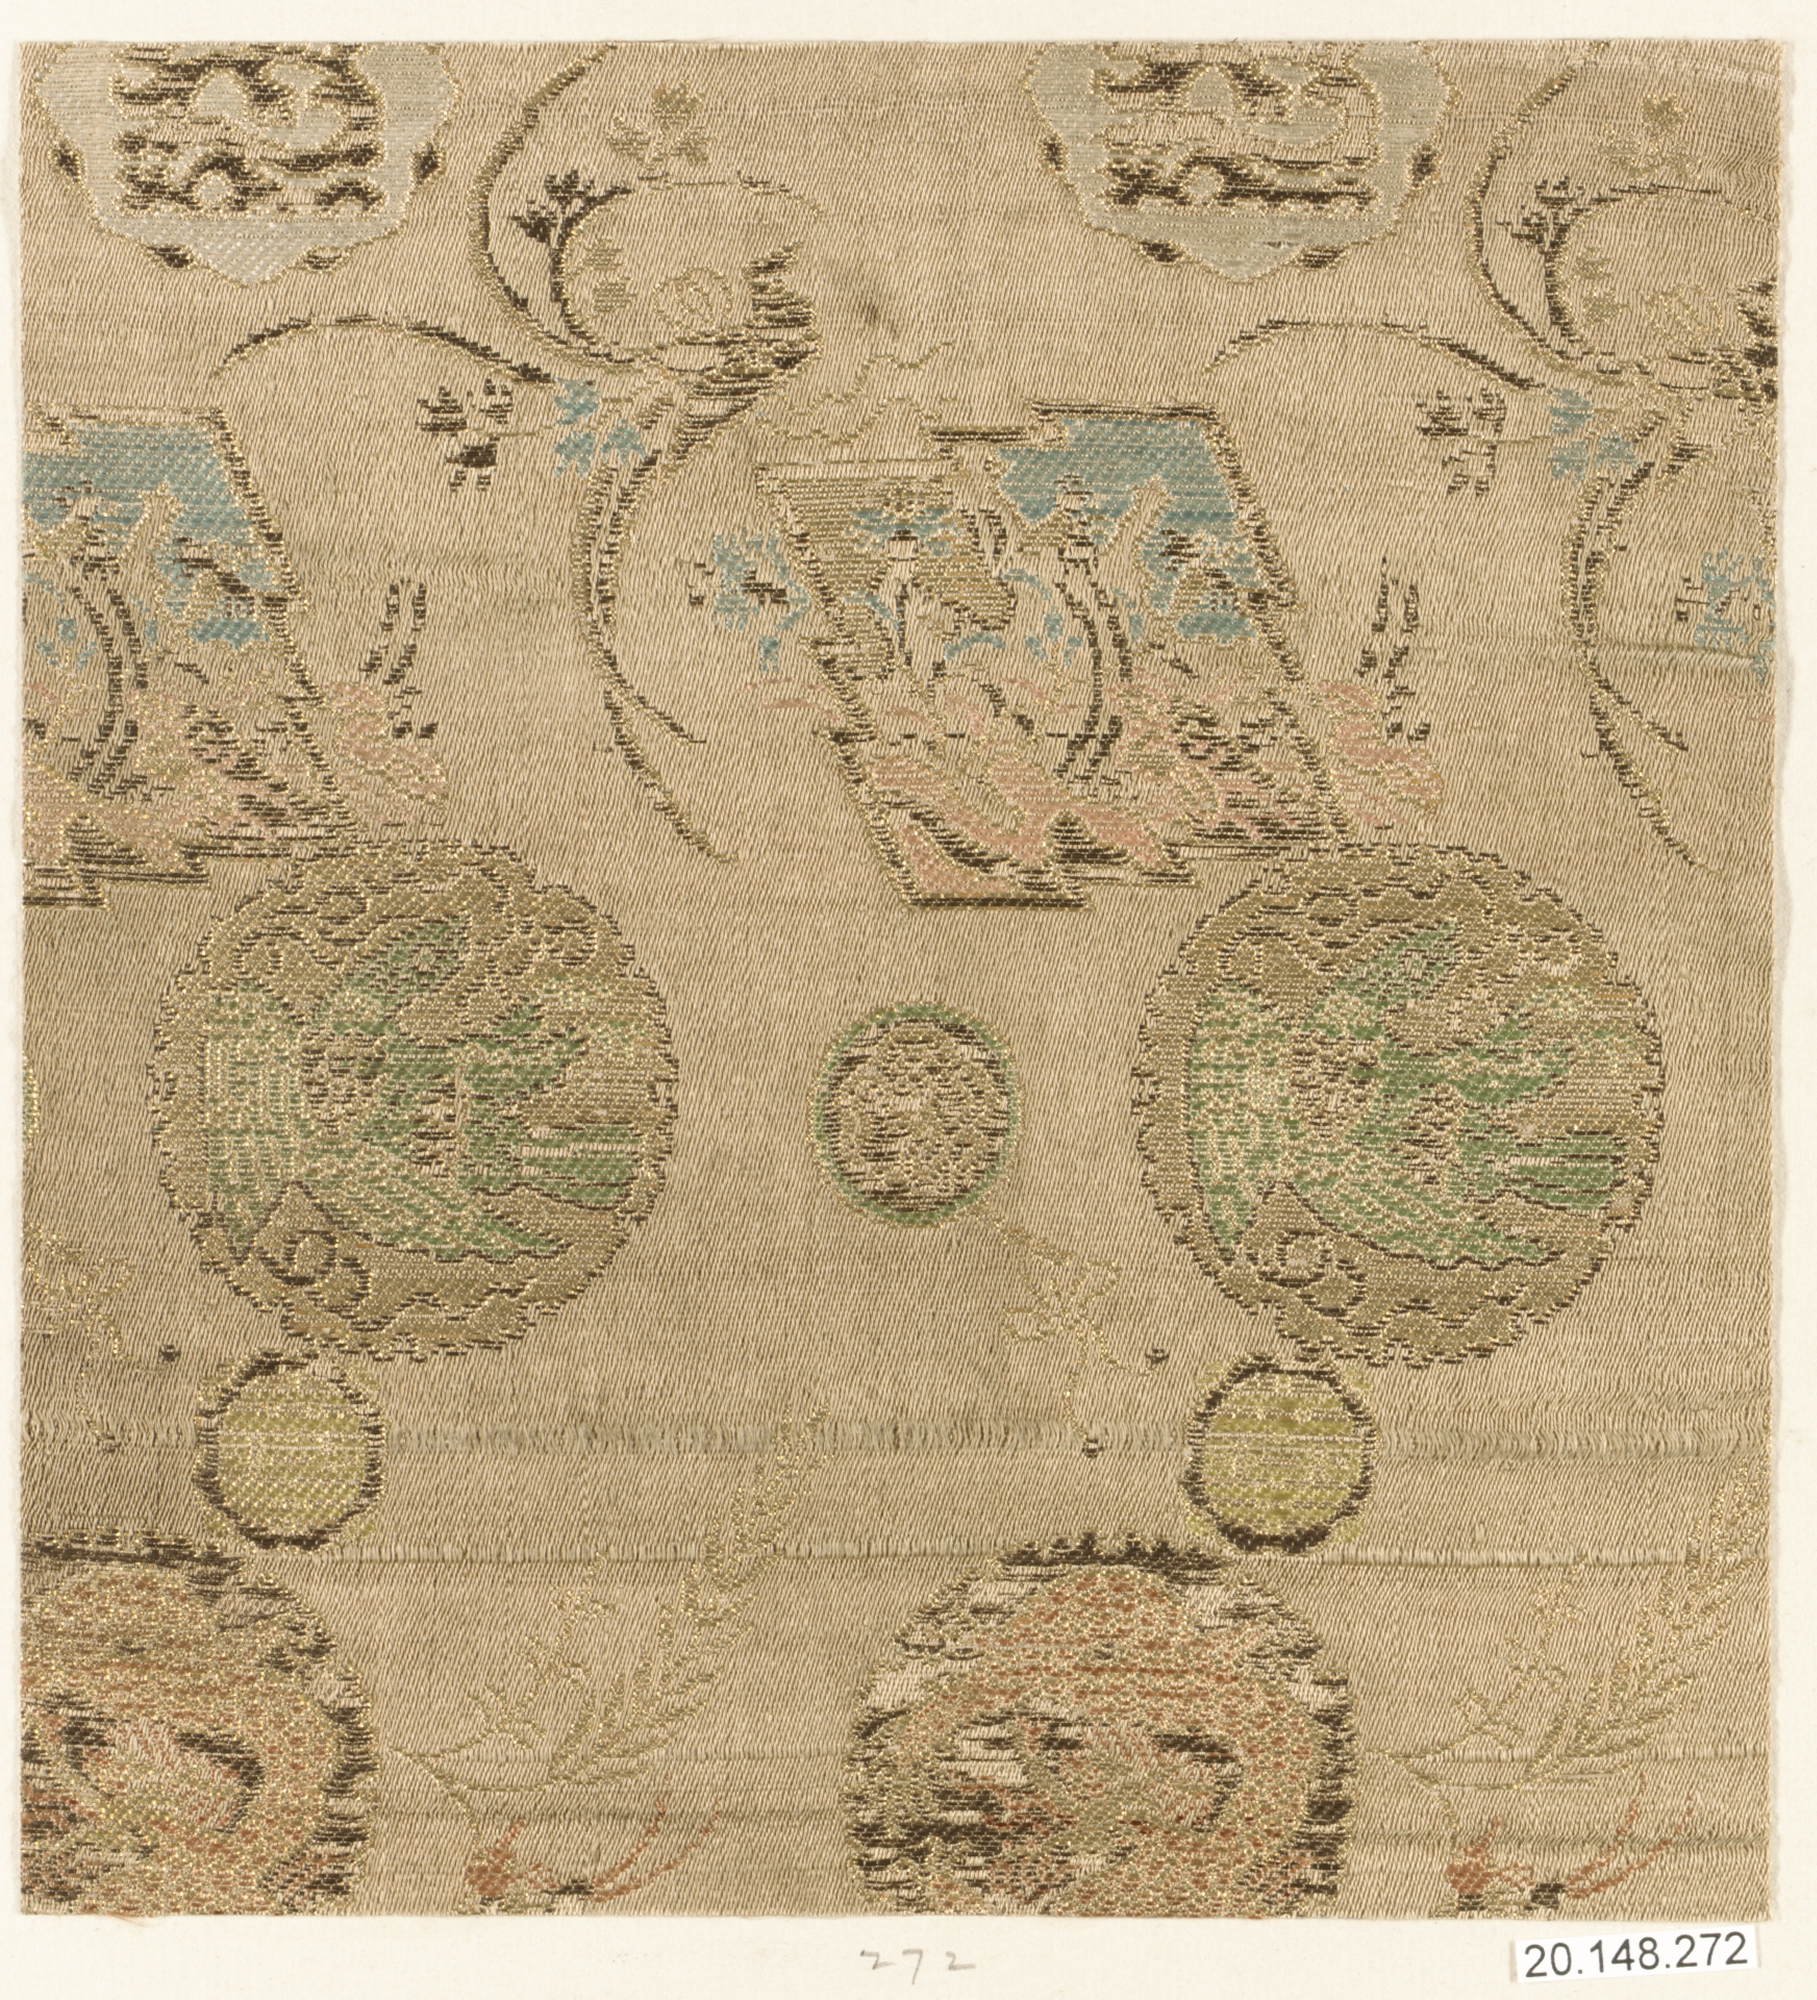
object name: piece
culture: japanese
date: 1701-1800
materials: silk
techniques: compound weave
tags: birds